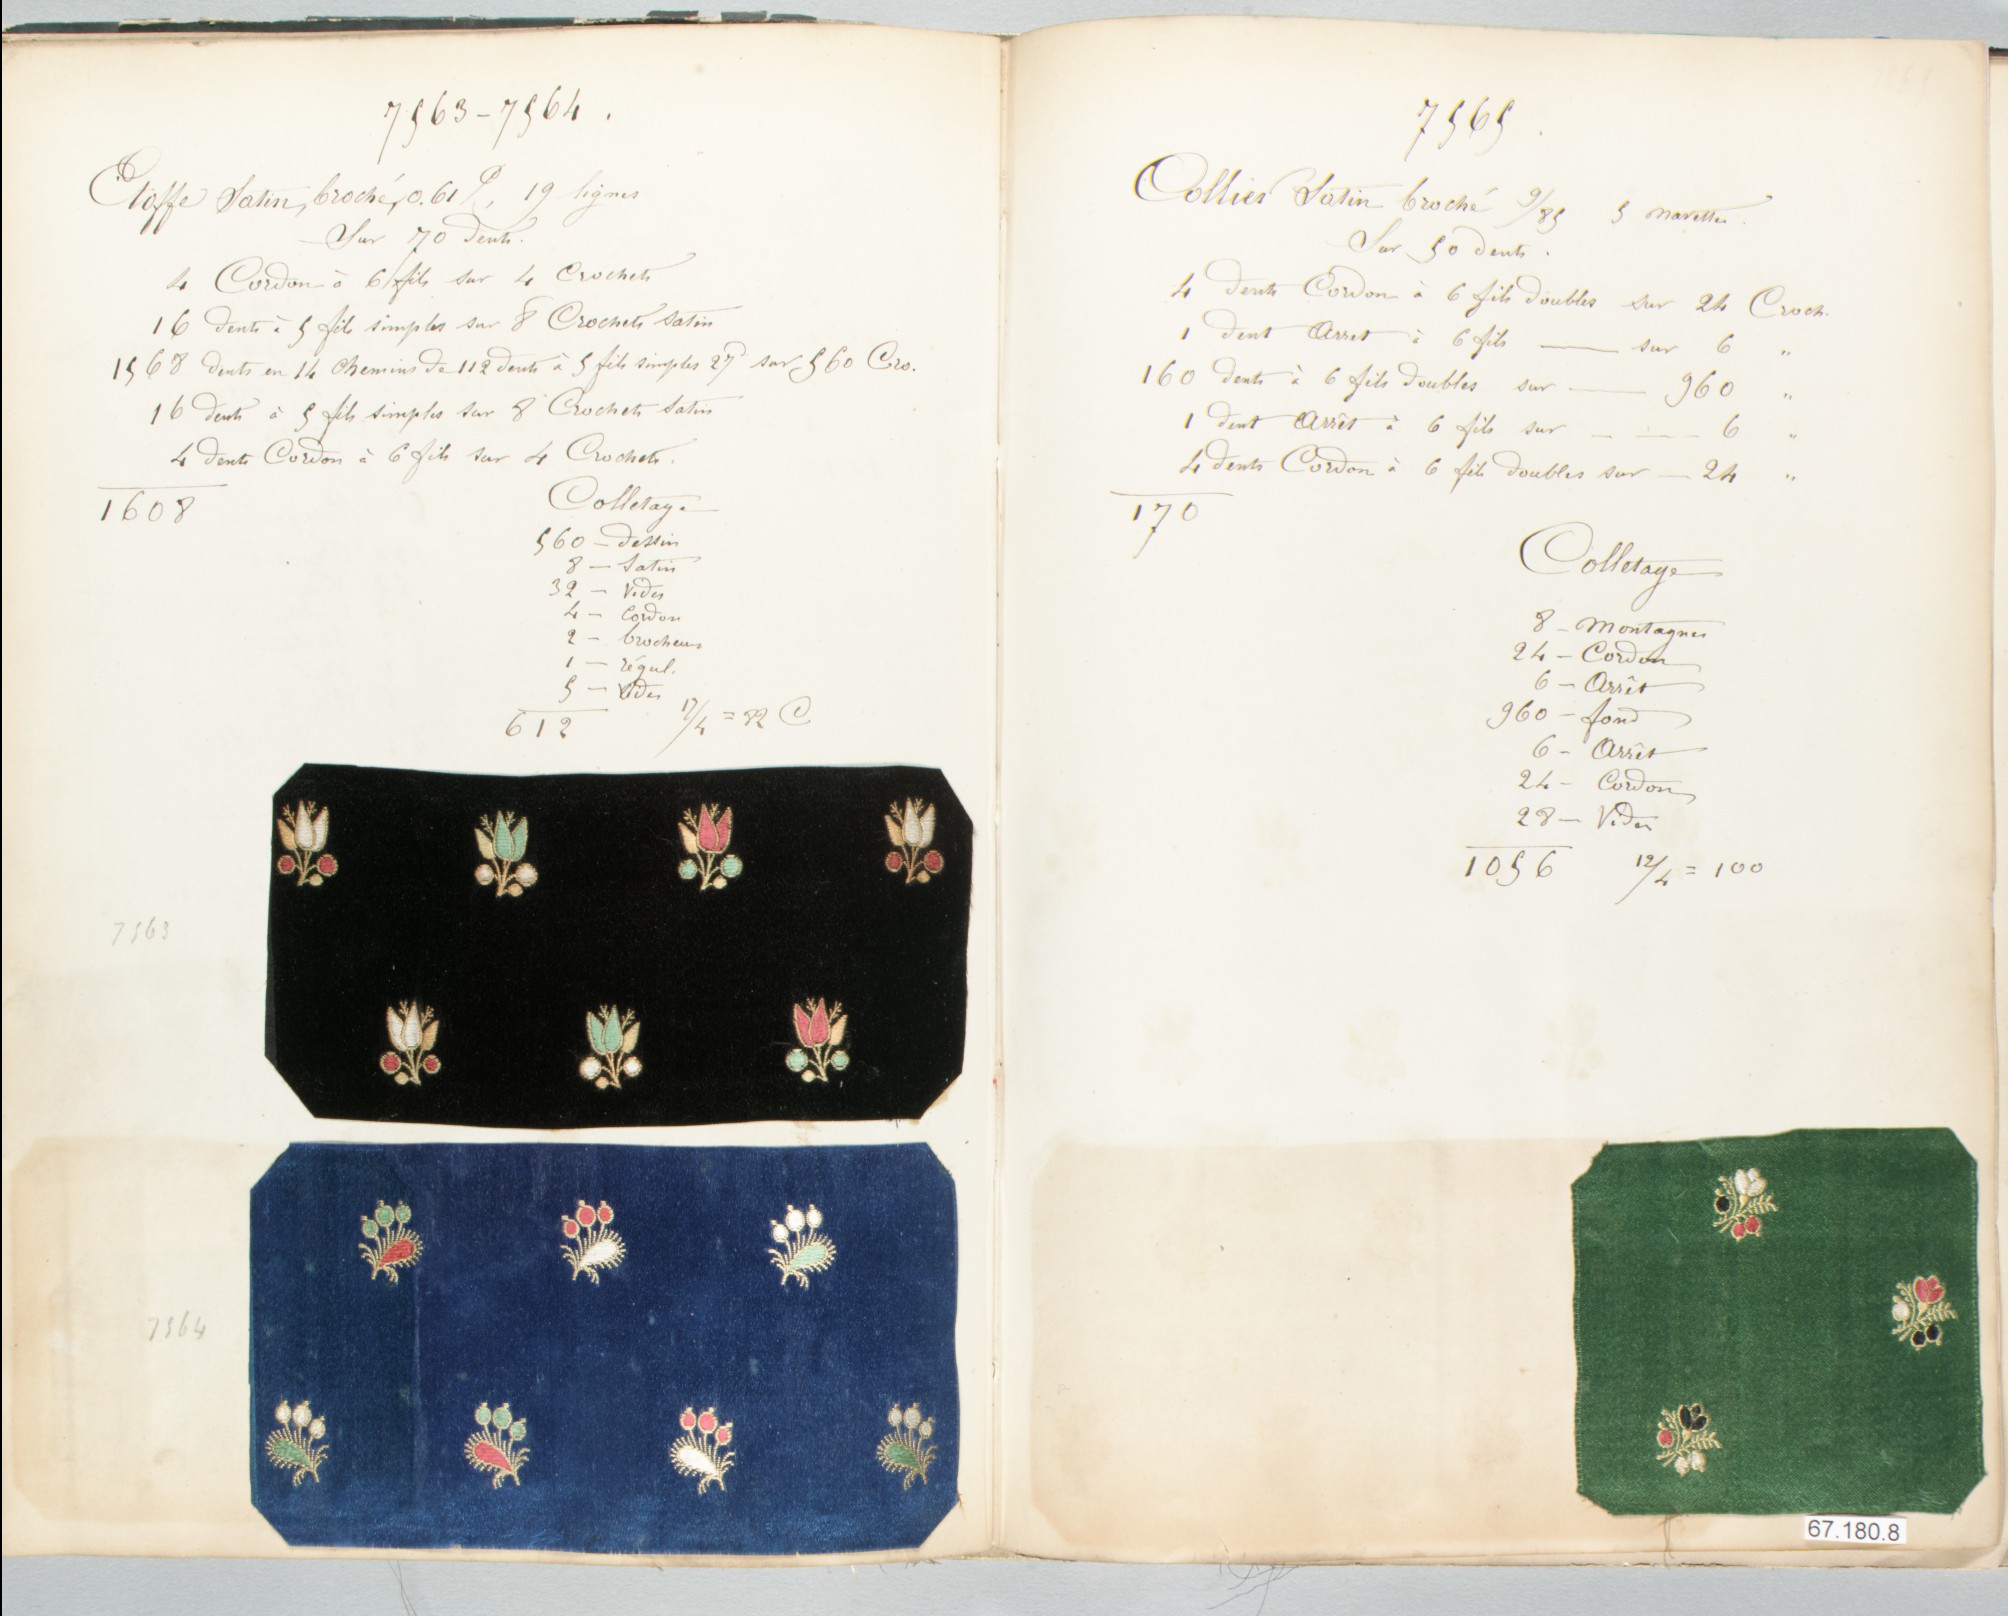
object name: sample book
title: Textile Sample Book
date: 1868